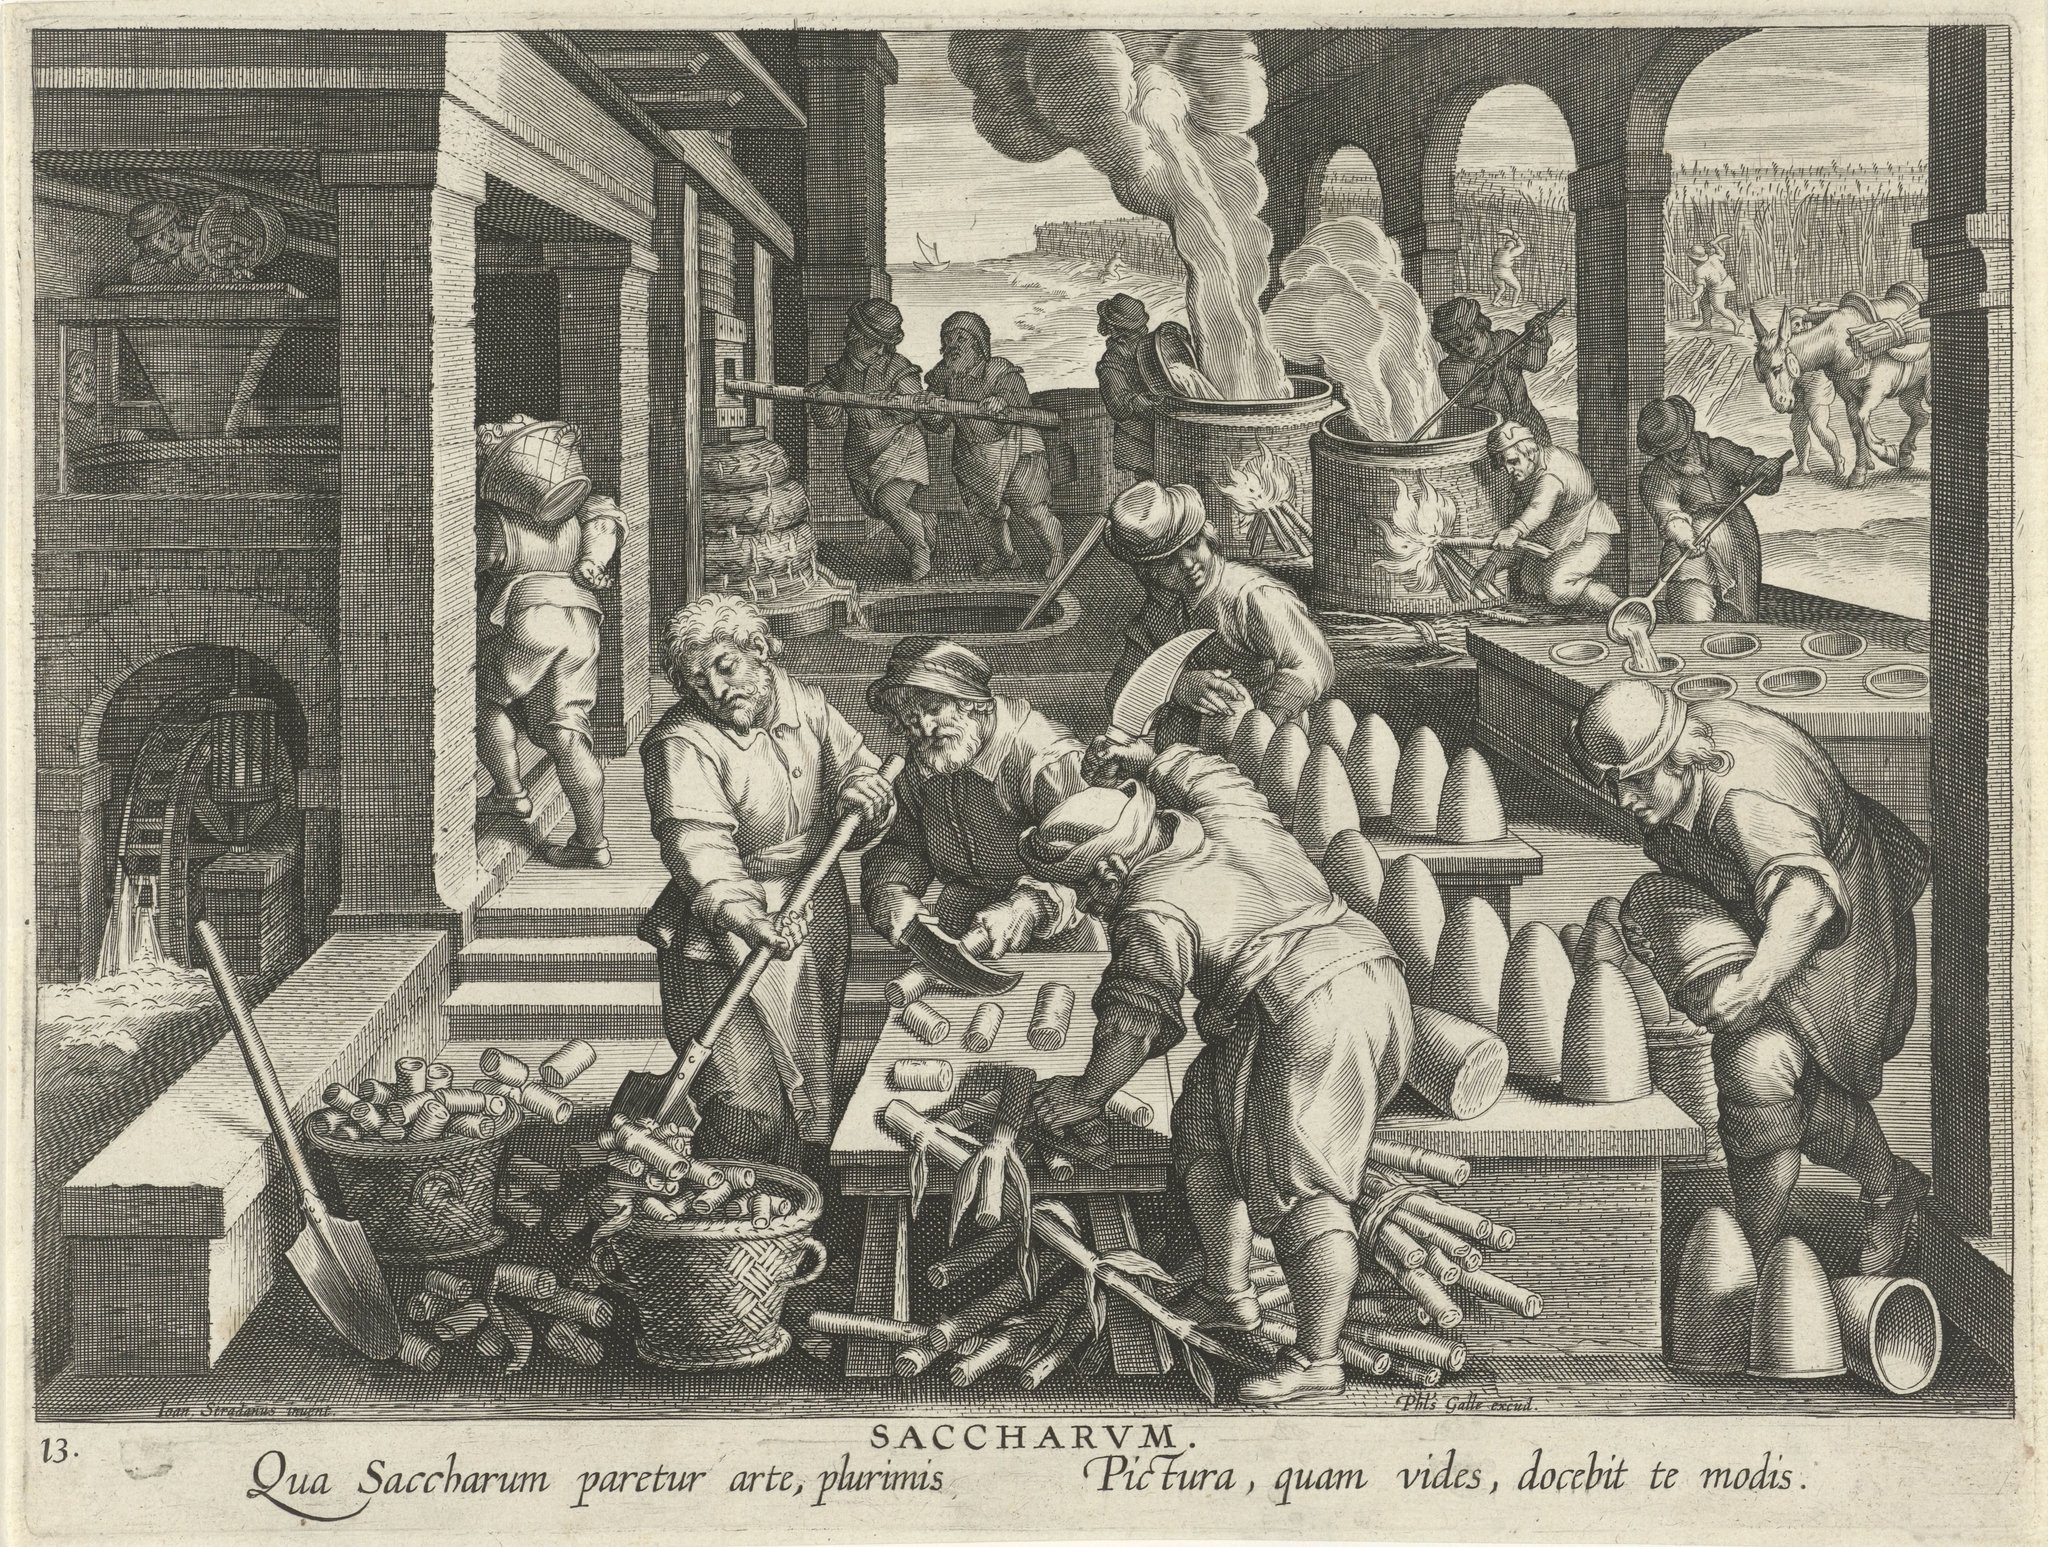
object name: print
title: Nova reperta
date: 1593-1598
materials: paper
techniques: engraving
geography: florence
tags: workshop, invention, discovery ~ science and technology, tools, aids, implements ~ crafts and industries: press (+ plant material ~ crafts, industries, agriculture), plants and herbs: sugarcane, sugar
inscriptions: collector's mark: Lugt 240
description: In een werkplaats wordt suikerriet in stukken gehakt en in manden naar een watermolen gebracht. Daar wordt het suikerriet gemalen. Vervolgens wordt het gemalen pulp geplet en wordt er siroop van gebrouwen. Daarna wordt de siroop gekristalliseerd en in kegels gegoten. Op de achtergrond het oogsten van suikerriet. De prent heeft een Latijns onderschrift en maakt deel uit van een negentiendelige serie over nieuwe uitvindingen en ontdekkingen.